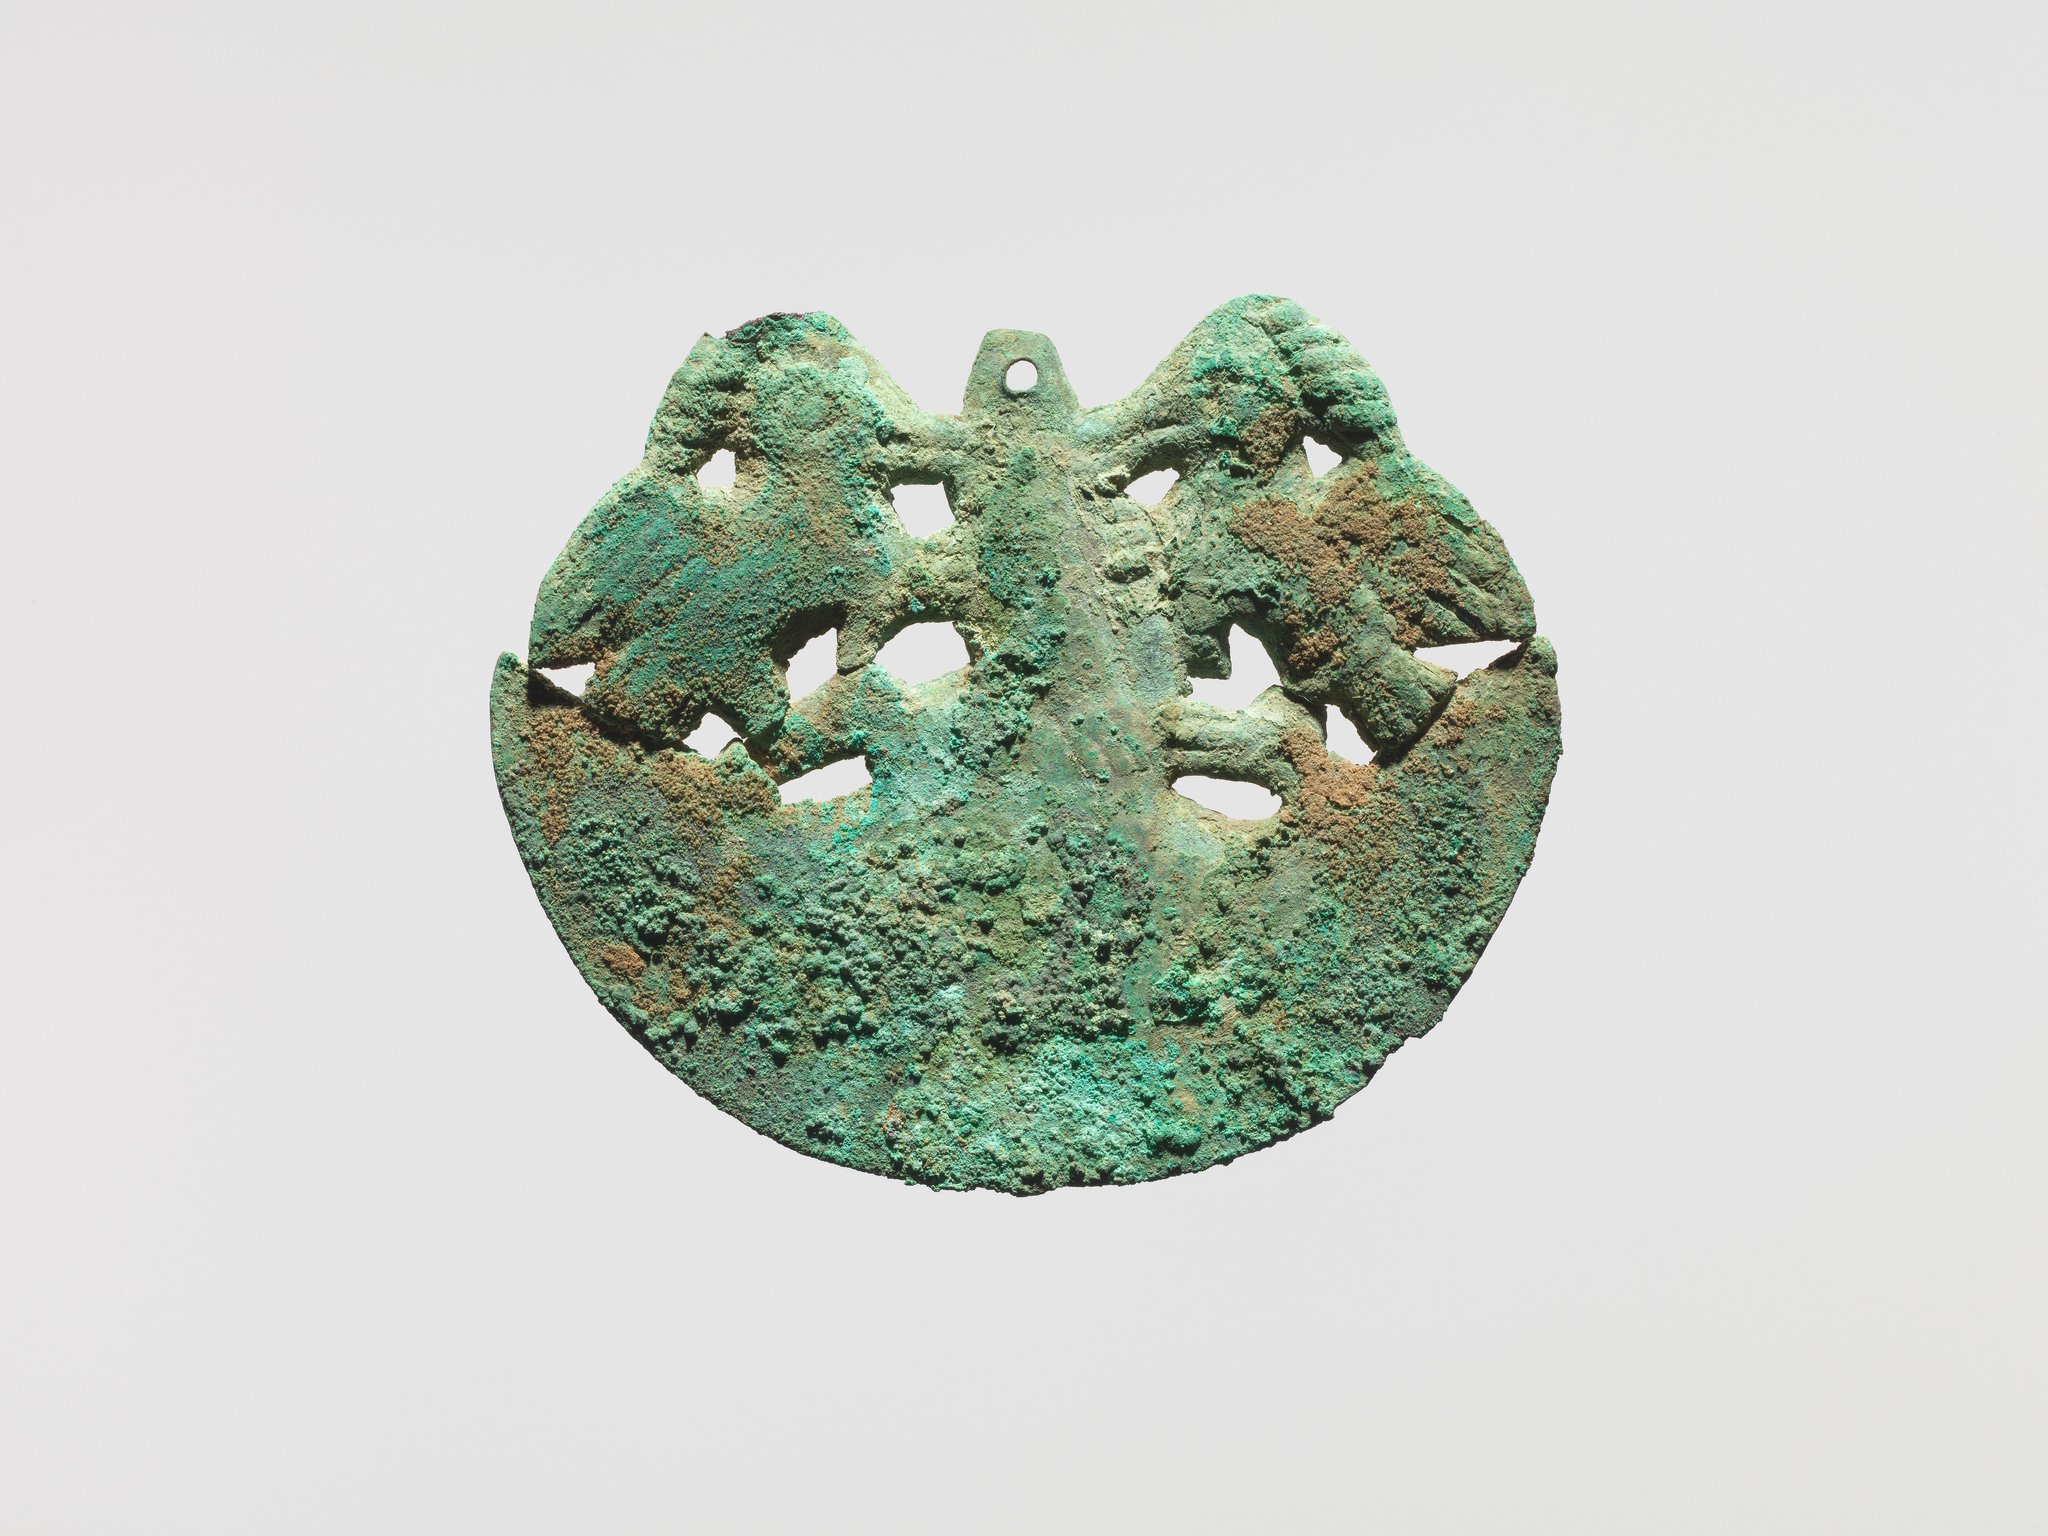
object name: ornament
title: Crescent Ornament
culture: moche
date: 501-700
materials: copper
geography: peru